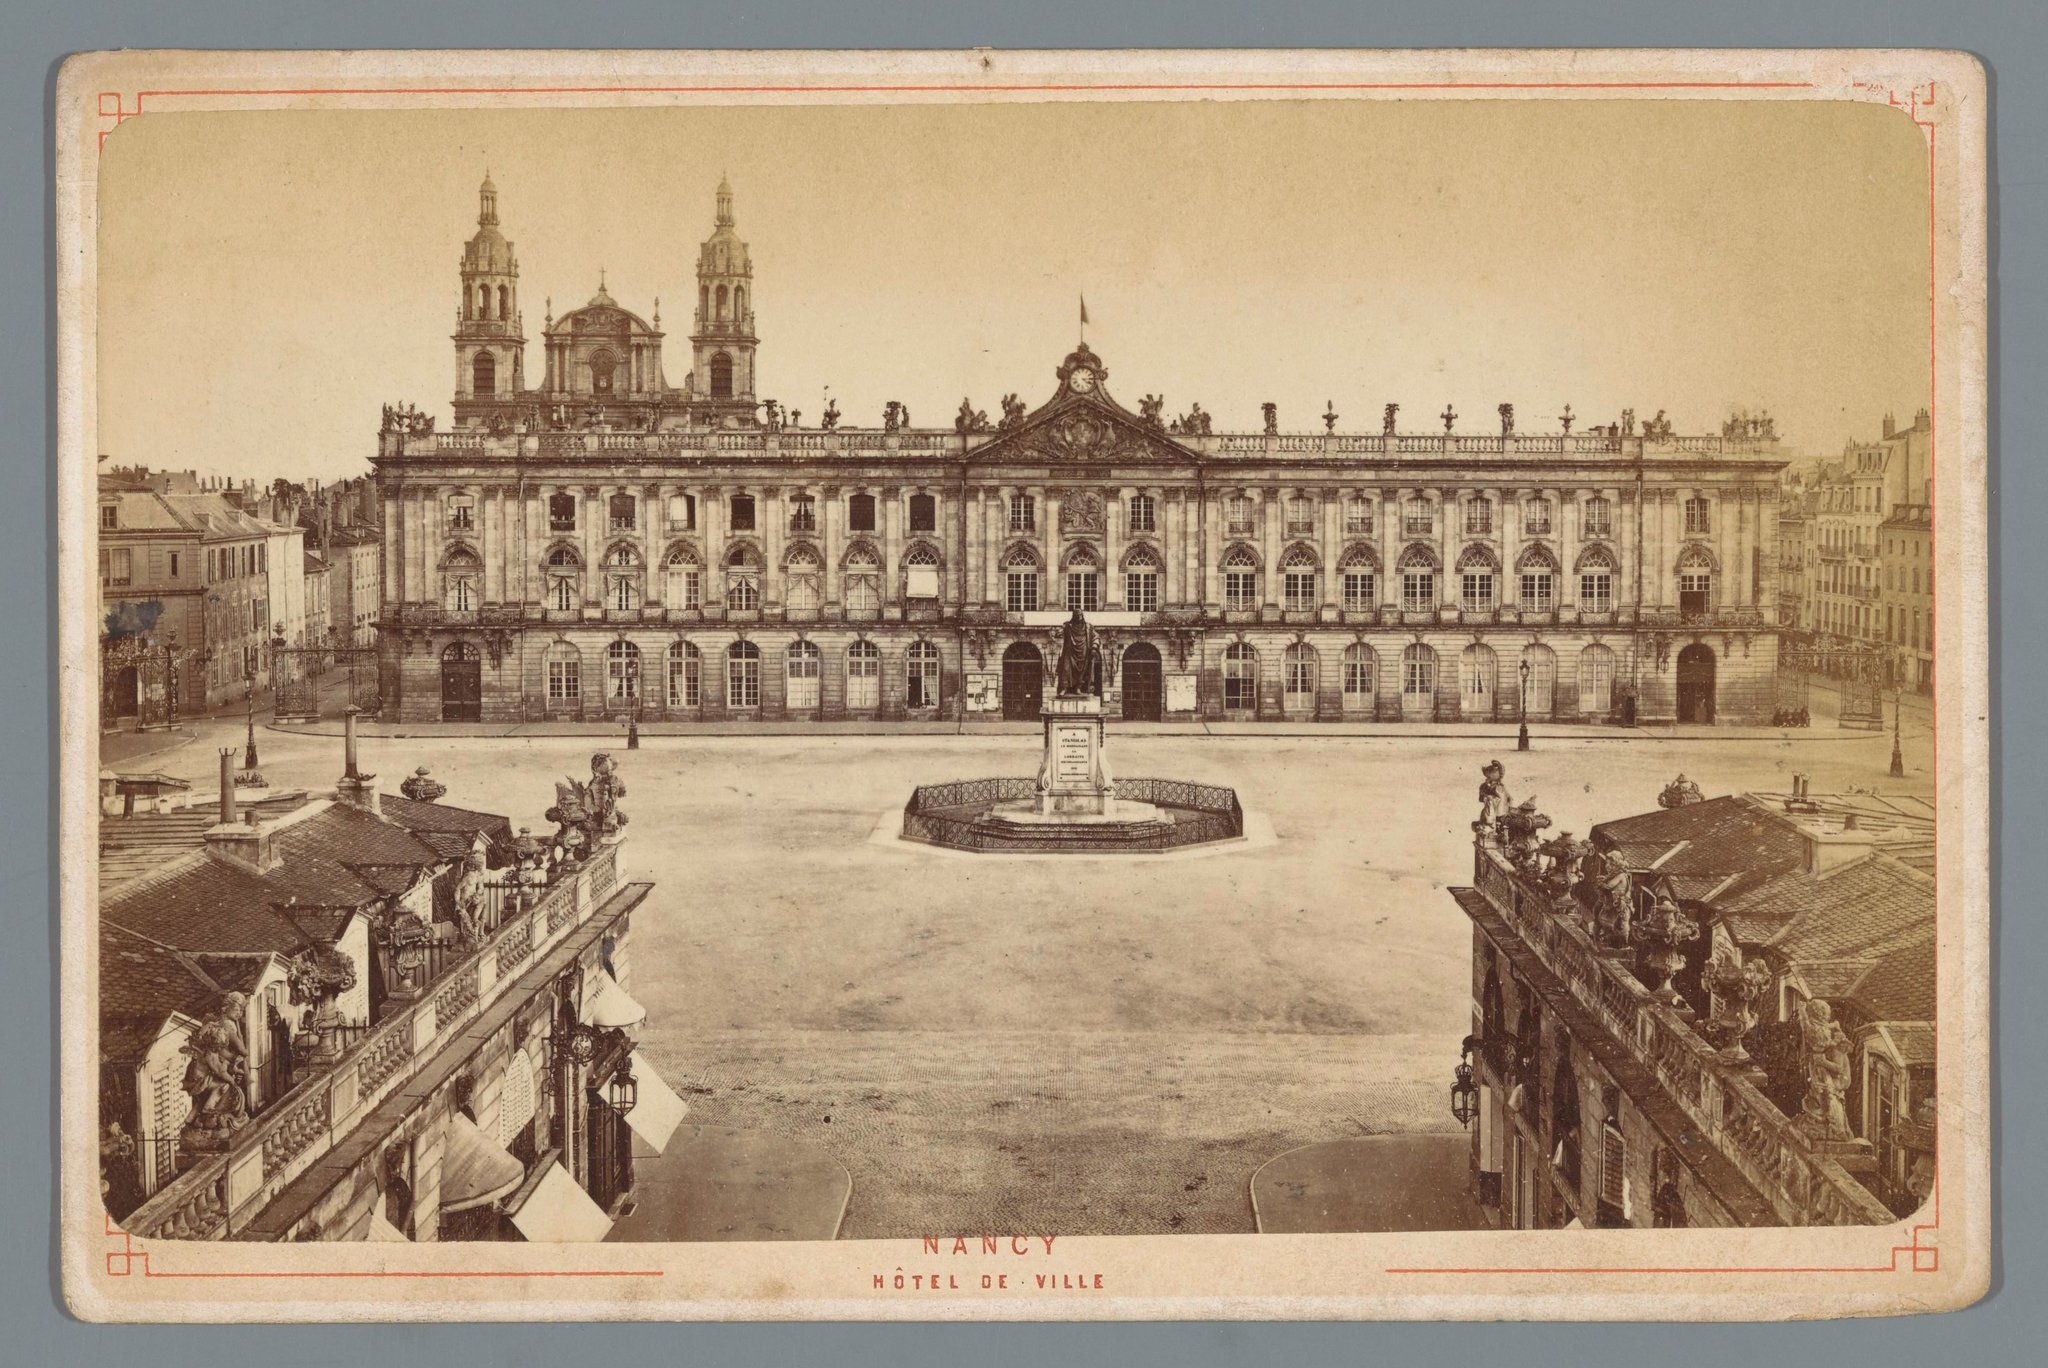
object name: cabinet photograph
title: Hôtel de ville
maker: Anonymous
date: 1875-1930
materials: cardboard, photographic support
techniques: albumen print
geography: nancy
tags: square, place, circus, etc., townhall